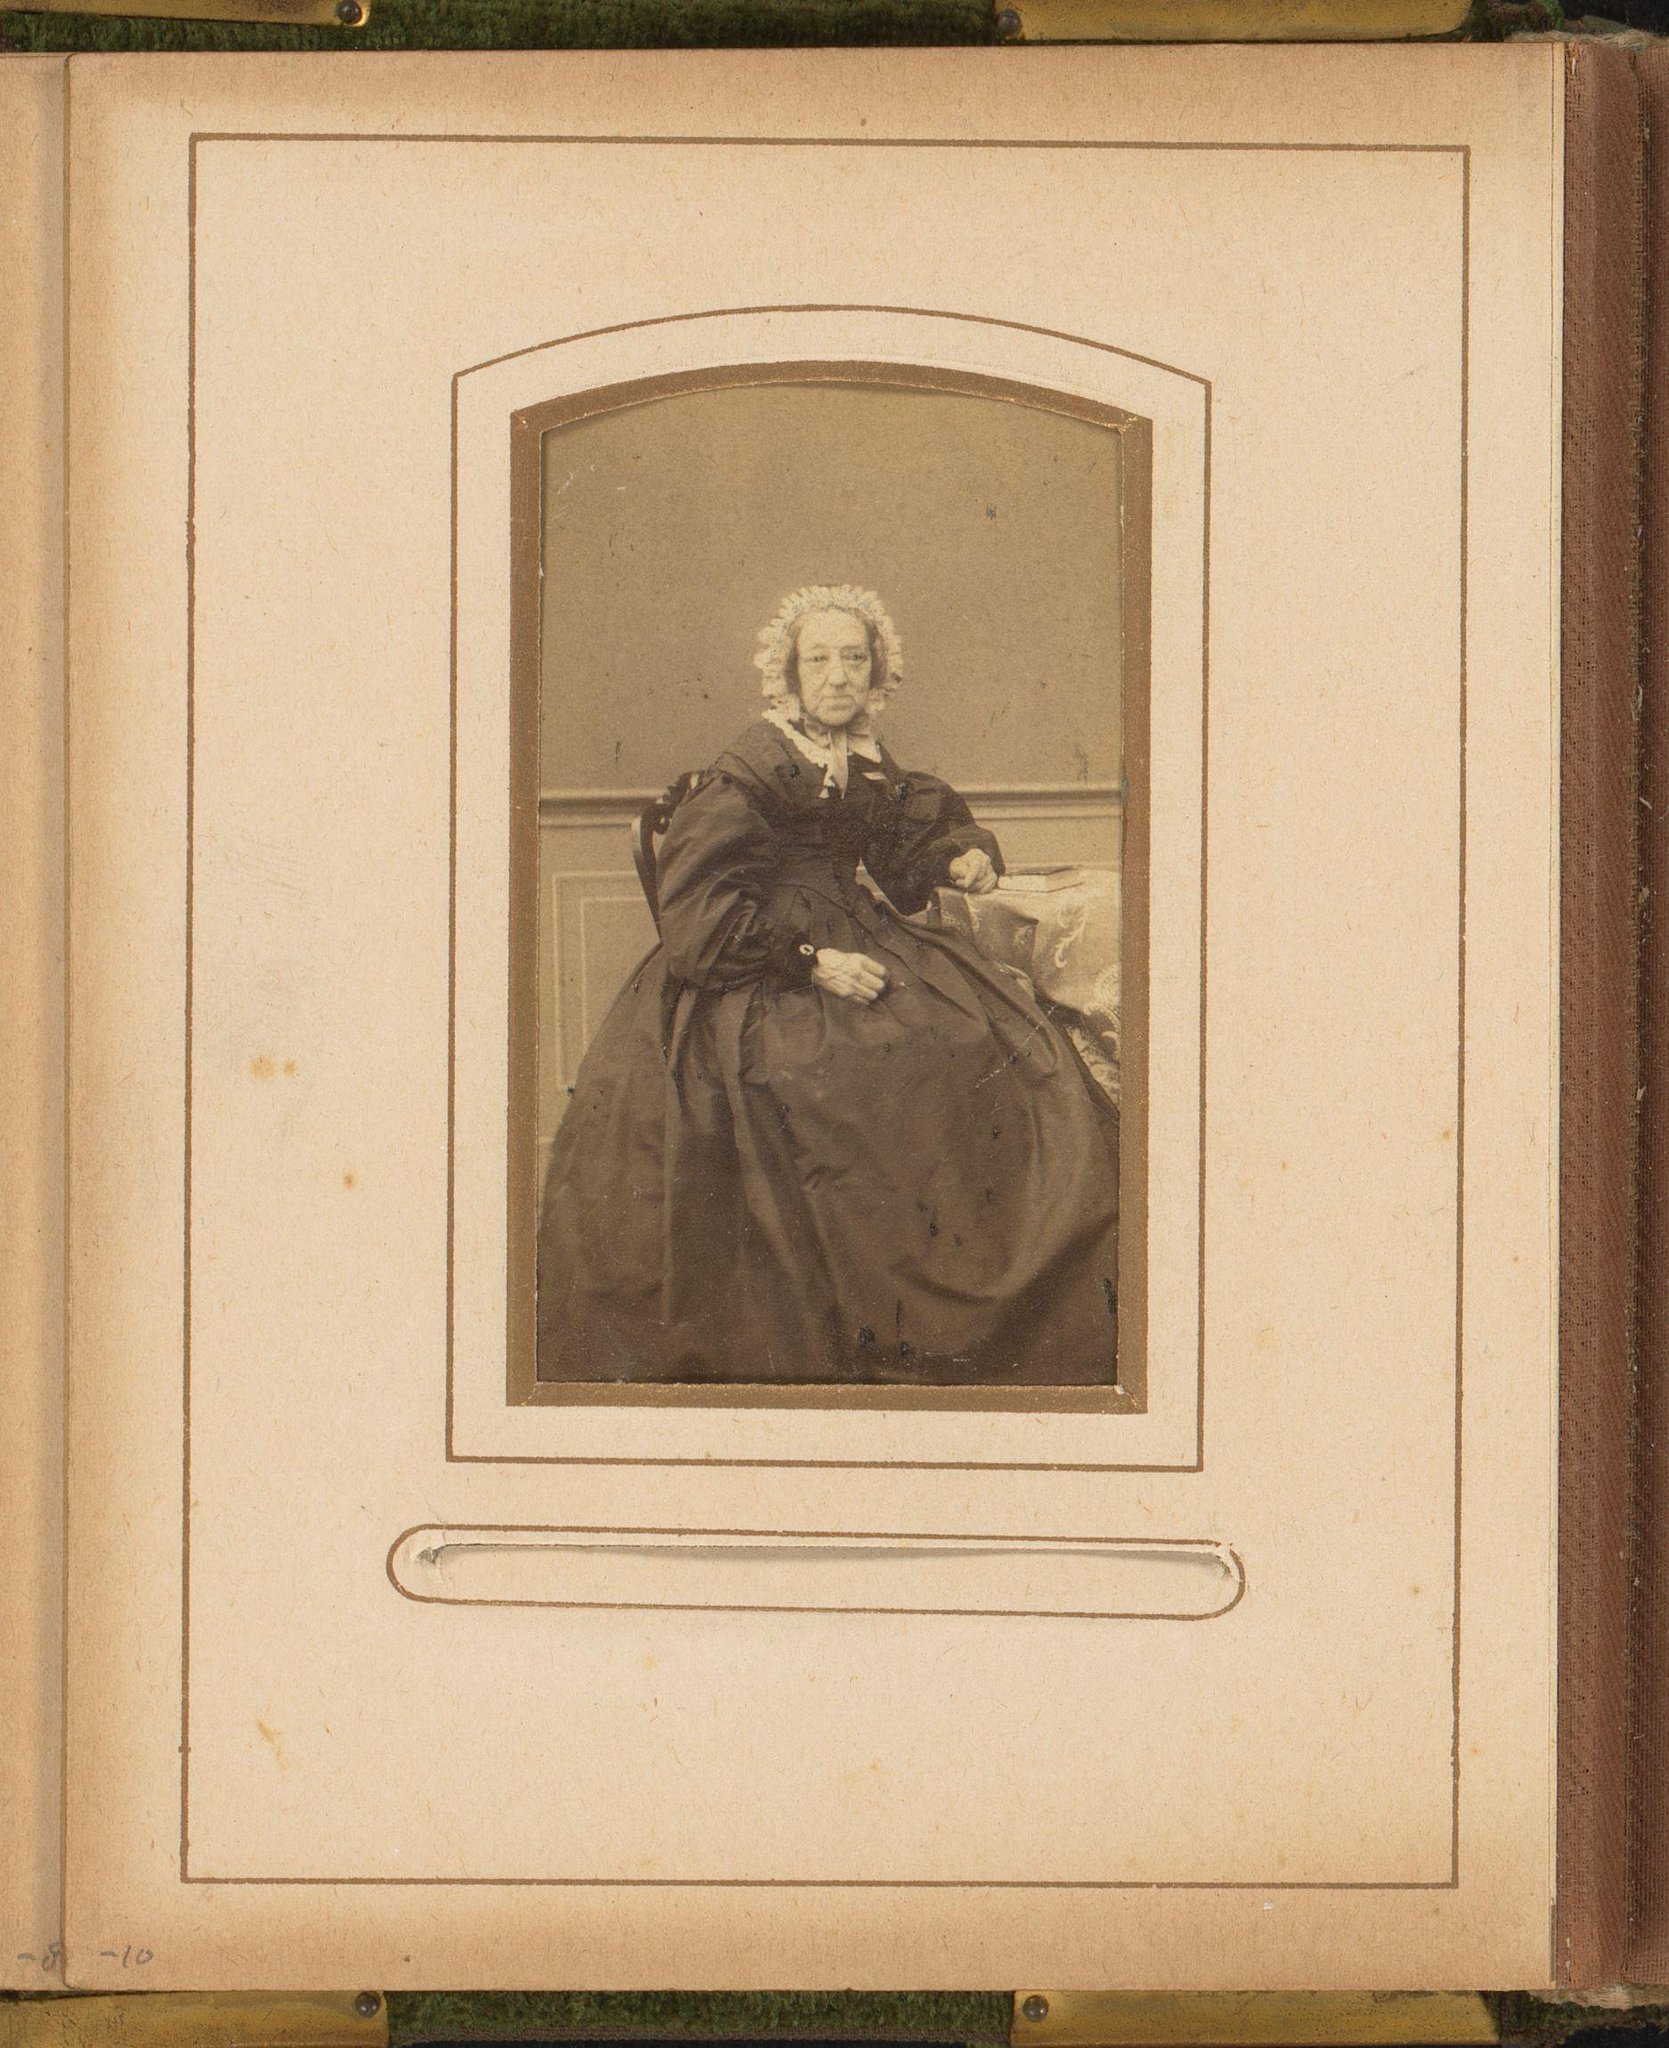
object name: carte de visite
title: Portret van een oude vrouw, mogelijk lid van de familie Beucker Andreae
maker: Anonymous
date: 1854-1885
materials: cardboard, paper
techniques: albumen print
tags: adult man, anonymous historical person portrayed